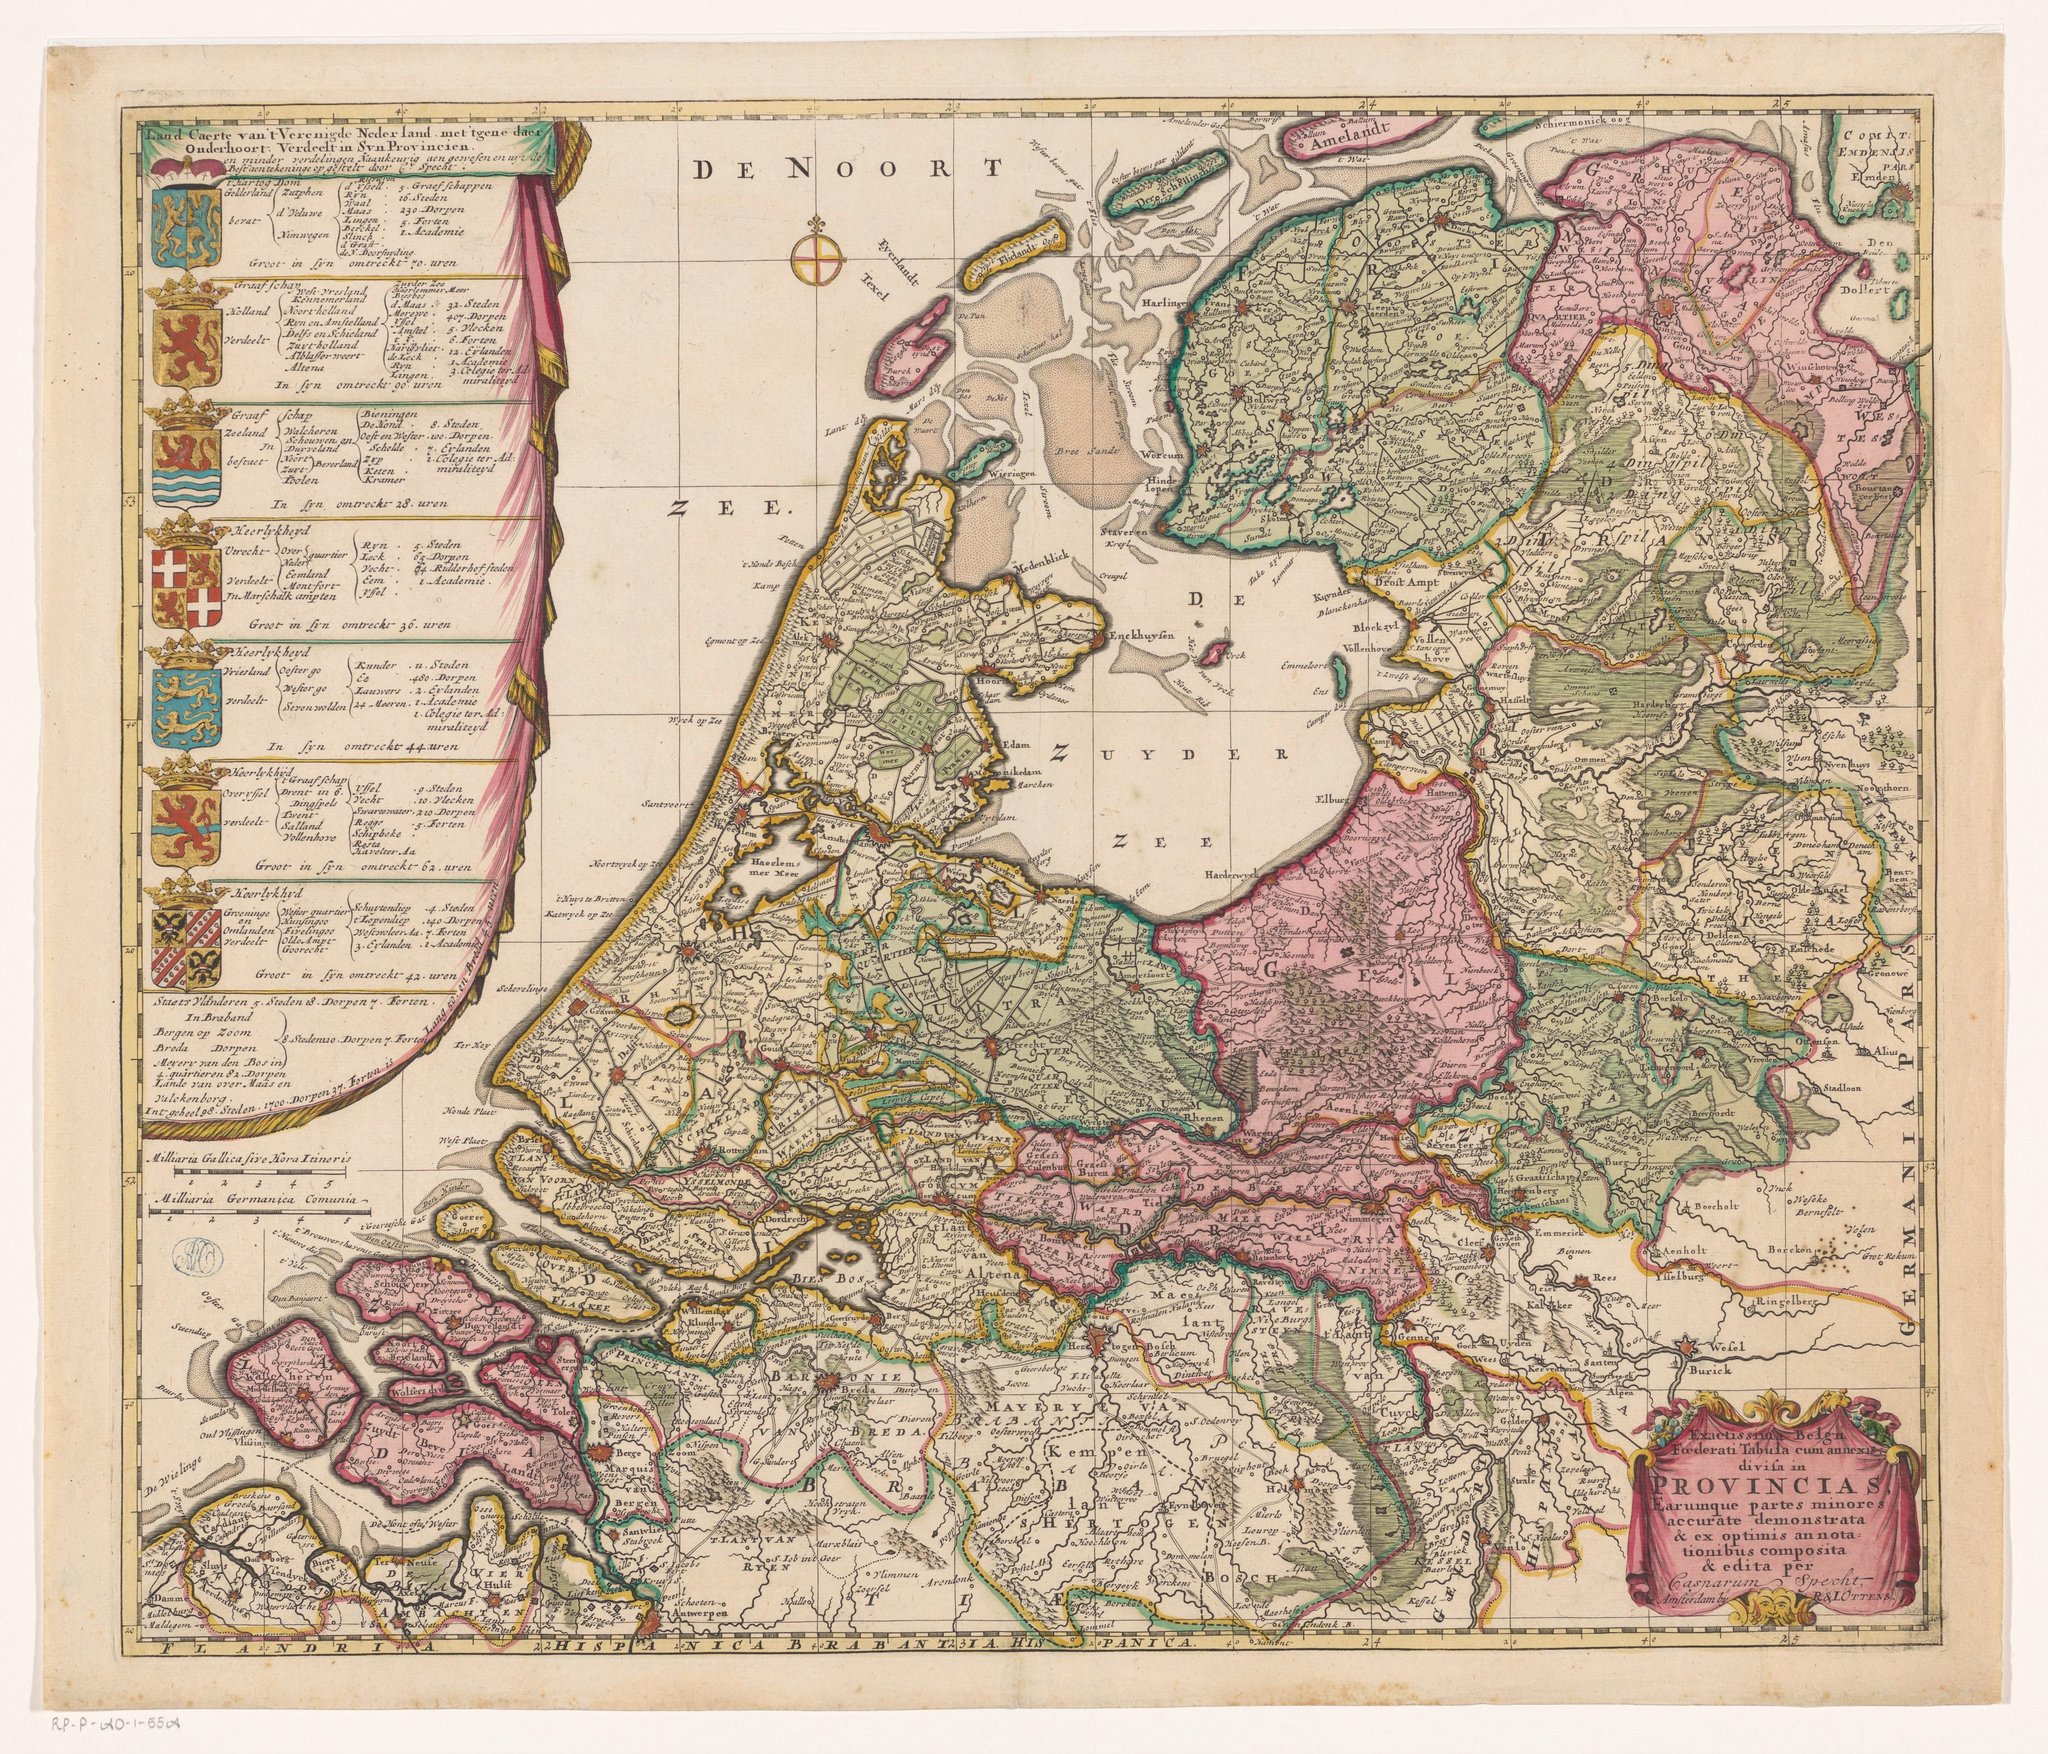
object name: map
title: Land caerte van 't Verenigde Nederland met 't gene daer onderhoort verdeelt in syn Provincien (...) / Exactissima Belgii Foederati tabula cum annexis divisa in provincias (...)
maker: caspar specht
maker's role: print maker, publisher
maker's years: 1654-1710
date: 1702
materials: paper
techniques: engraving, hand coloring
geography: amsterdam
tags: maps of separate countries or regions, coat of arms (as symbol of the state, etc.) (+ province; provincial), netherlands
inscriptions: collector's mark: Lugt 2228, collector's mark: Lugt 195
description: Links een langwerpige cartouche met daarin de Nederlandse titel en de wapens van en topografische en staatkundige informatie over de Zeven Provinciën. Daaronder twee schaalstokken: Milliaria Gallica sive hora itineris, Milliaria Germanica comunia. Rechtsonder een cartouche met de Latijnse titel. De kaart is voorzien van een coördinaten-net en een gradenverdeling langs randen.